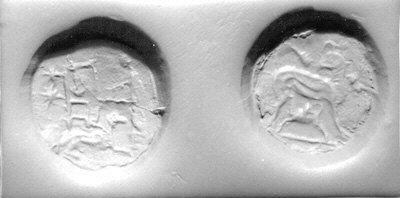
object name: stamp seal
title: Stamp seal (bifacial disk) with cultic scene and monsters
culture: assyrian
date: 734-601 BCE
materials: limestone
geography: mesopotamia